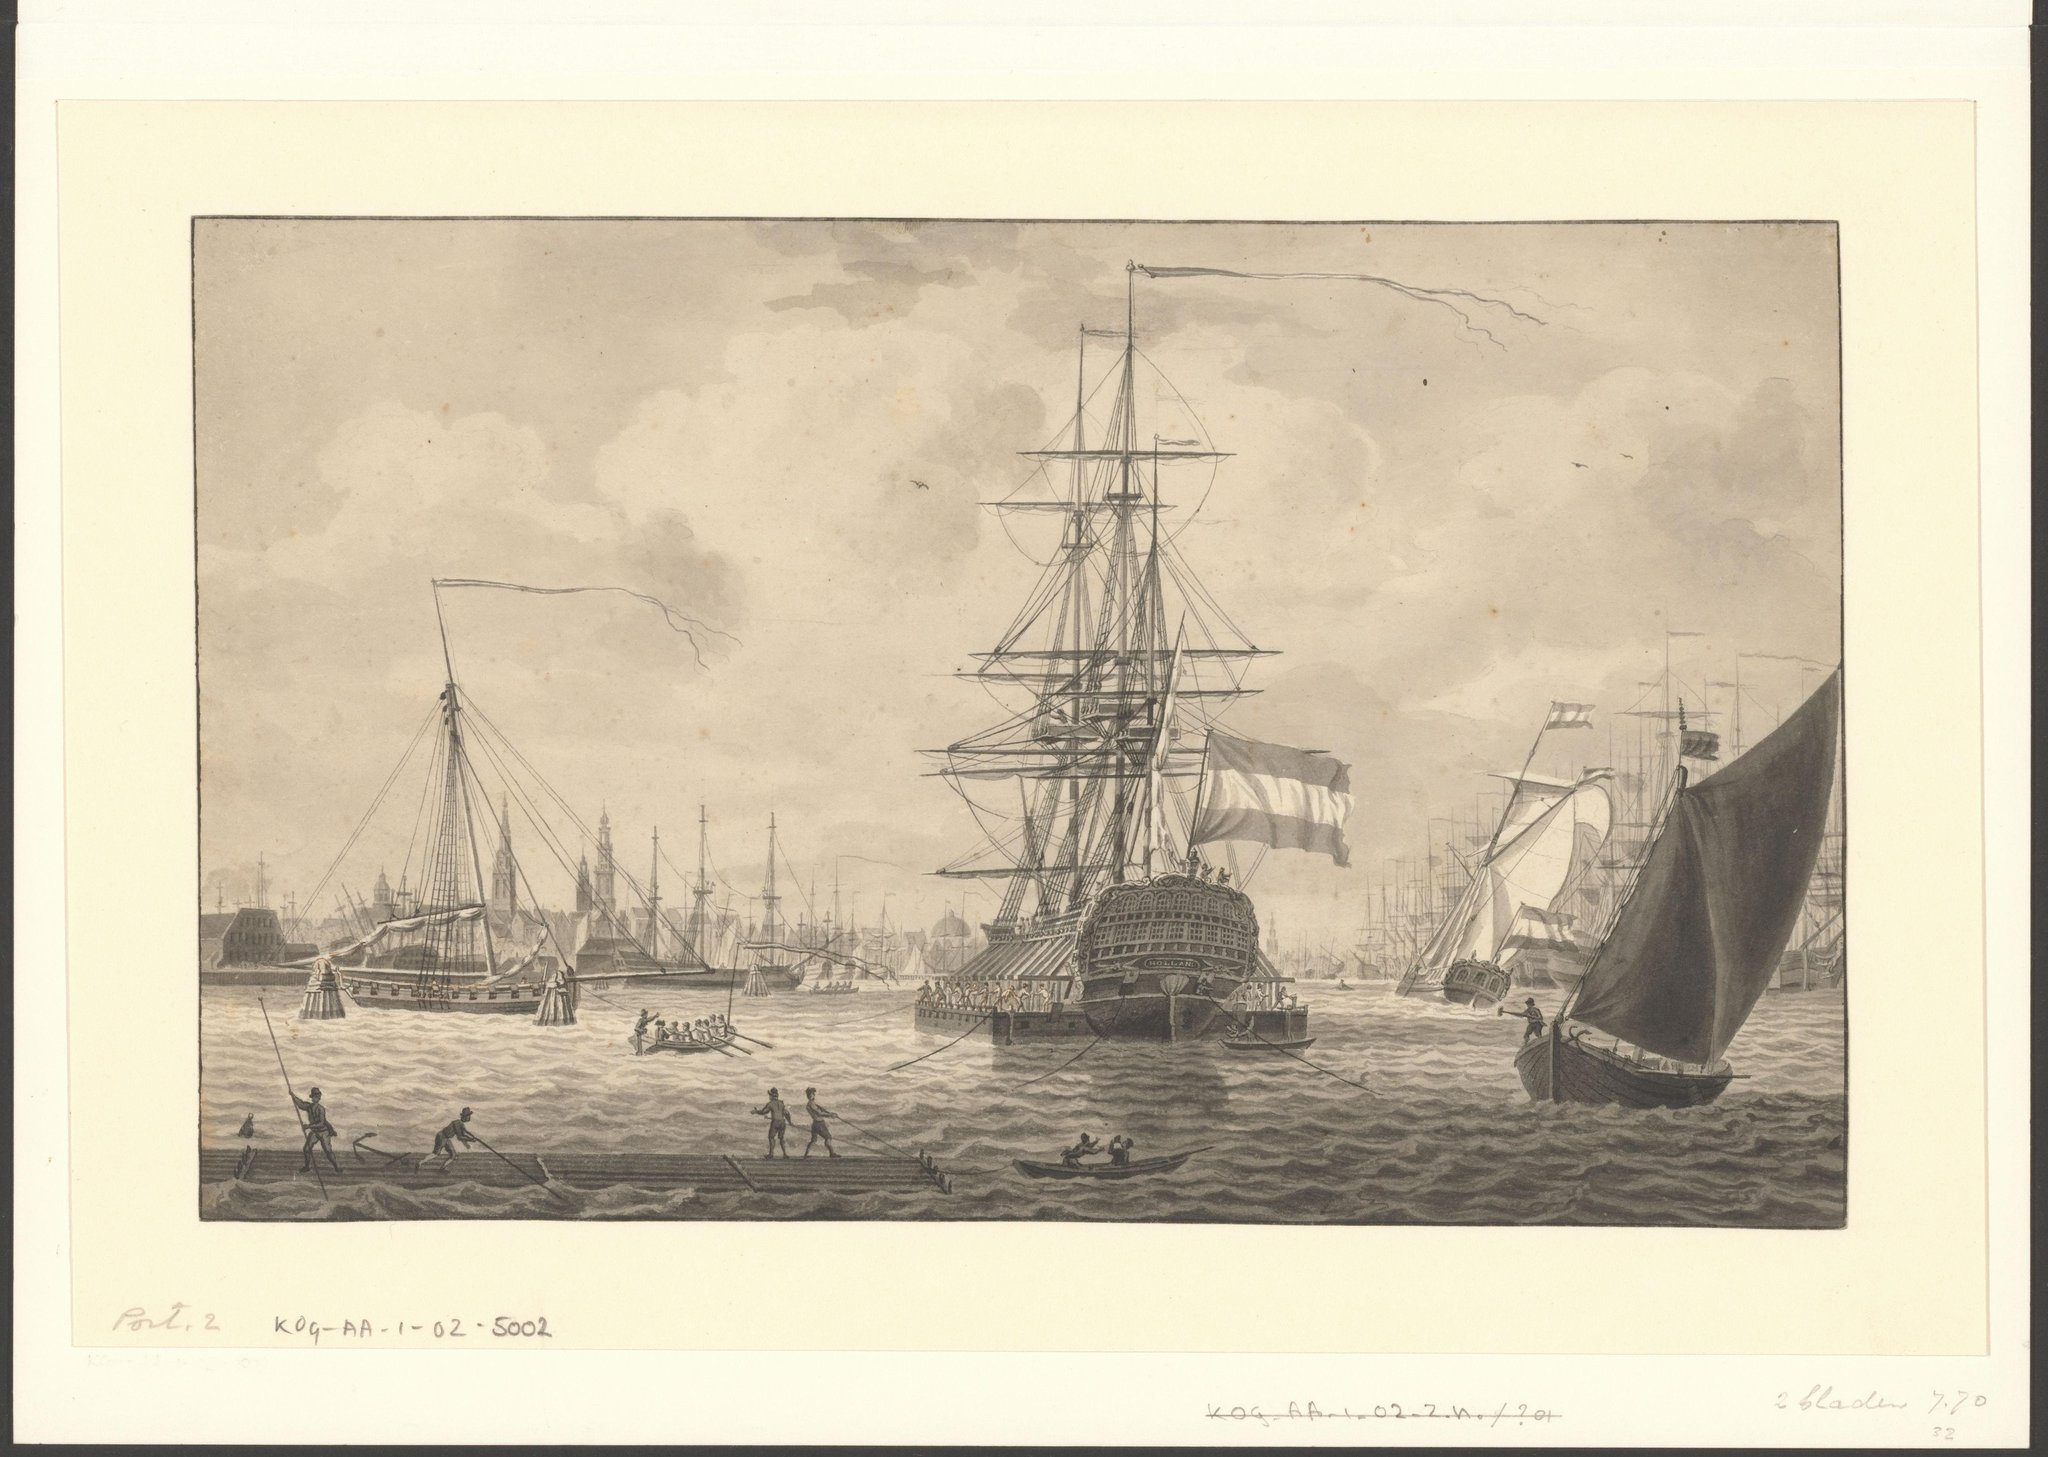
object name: drawing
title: Gezicht op de haven van Amsterdam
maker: dirk de jong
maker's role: draughtsman, print maker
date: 1781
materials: ink, paper, pencil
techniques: brush, pen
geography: amsterdam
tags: harbour, city-view in general; 'veduta', ships (in general), port of amsterdam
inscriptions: inscription: ‘Tweede Gezigt van (...) om te zien’, inscription: ‘Port. 2’, signature and date: ‘1781 / Dk de Jong’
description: Onderwerpsrubriek binnen de Atlas Amsterdam: Gezichten van het IJ op het westelijk gedeelte der stad, Blauwhoofd tot Nieuwebrug.